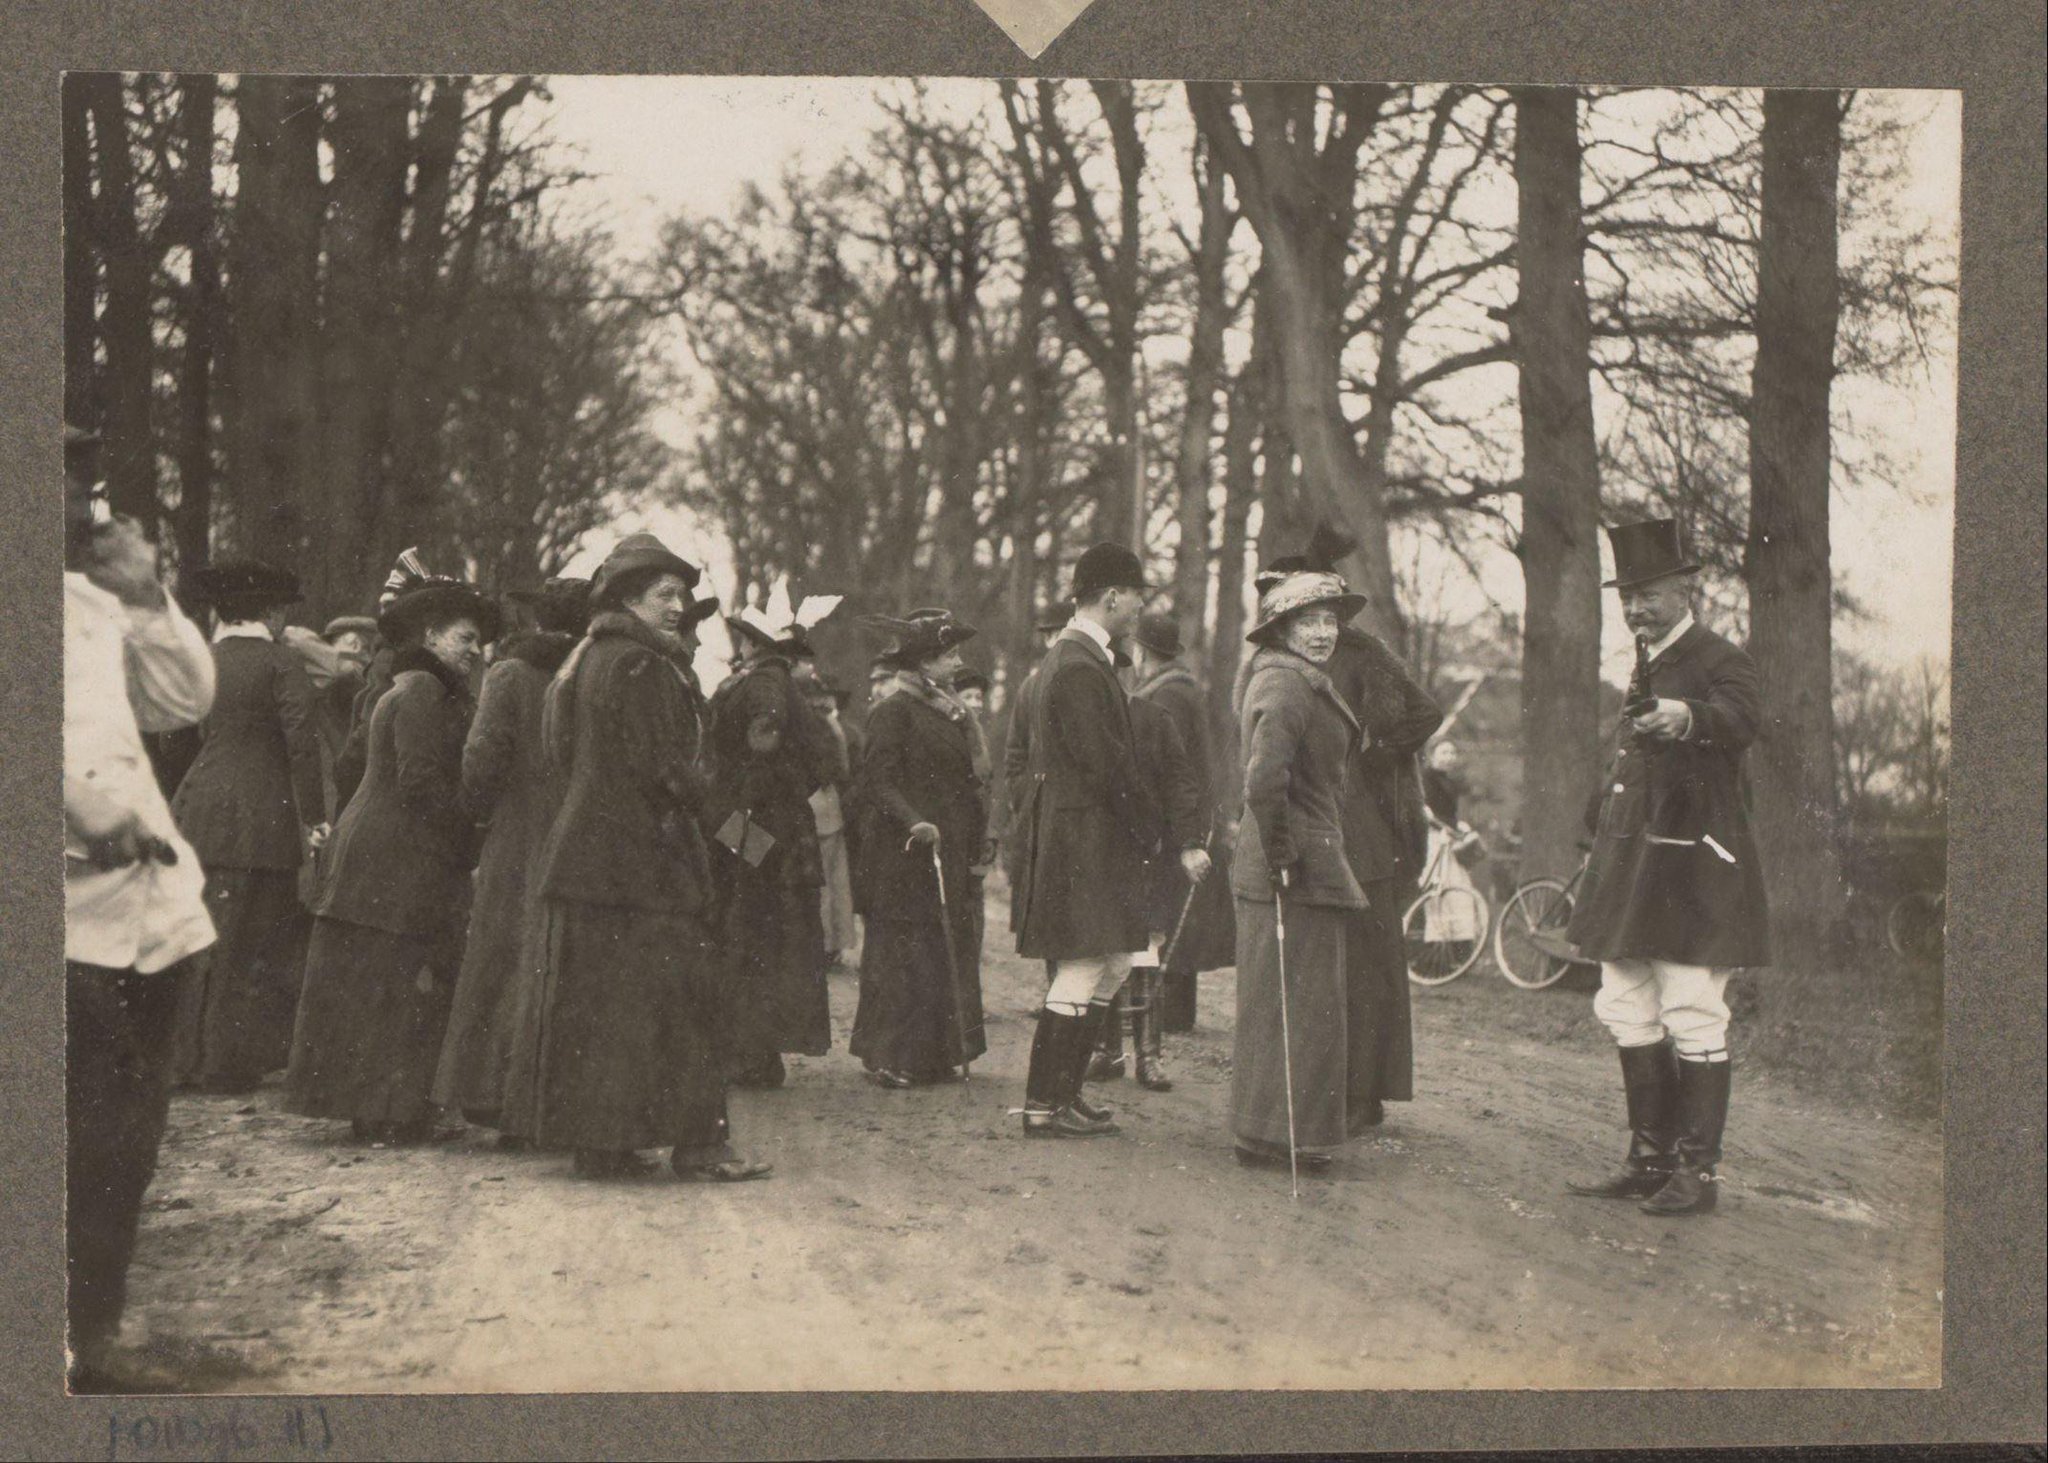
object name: album leaf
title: Ruitertafereel op Koninklijke Houtvesterij Het Loo: ruiters en publiek op een landweg, man betrapt de fotograaf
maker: Anonymous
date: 1900-1925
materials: photographic support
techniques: gelatin silver print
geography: het loo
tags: adult woman, hunting, chase, hunting-ground, forest path or lane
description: Onderdeel van Fotoalbum van de heer Brams, opperhoutvester van koningin Wilhelmina op Koninklijke Houtvesterij Het Loo.